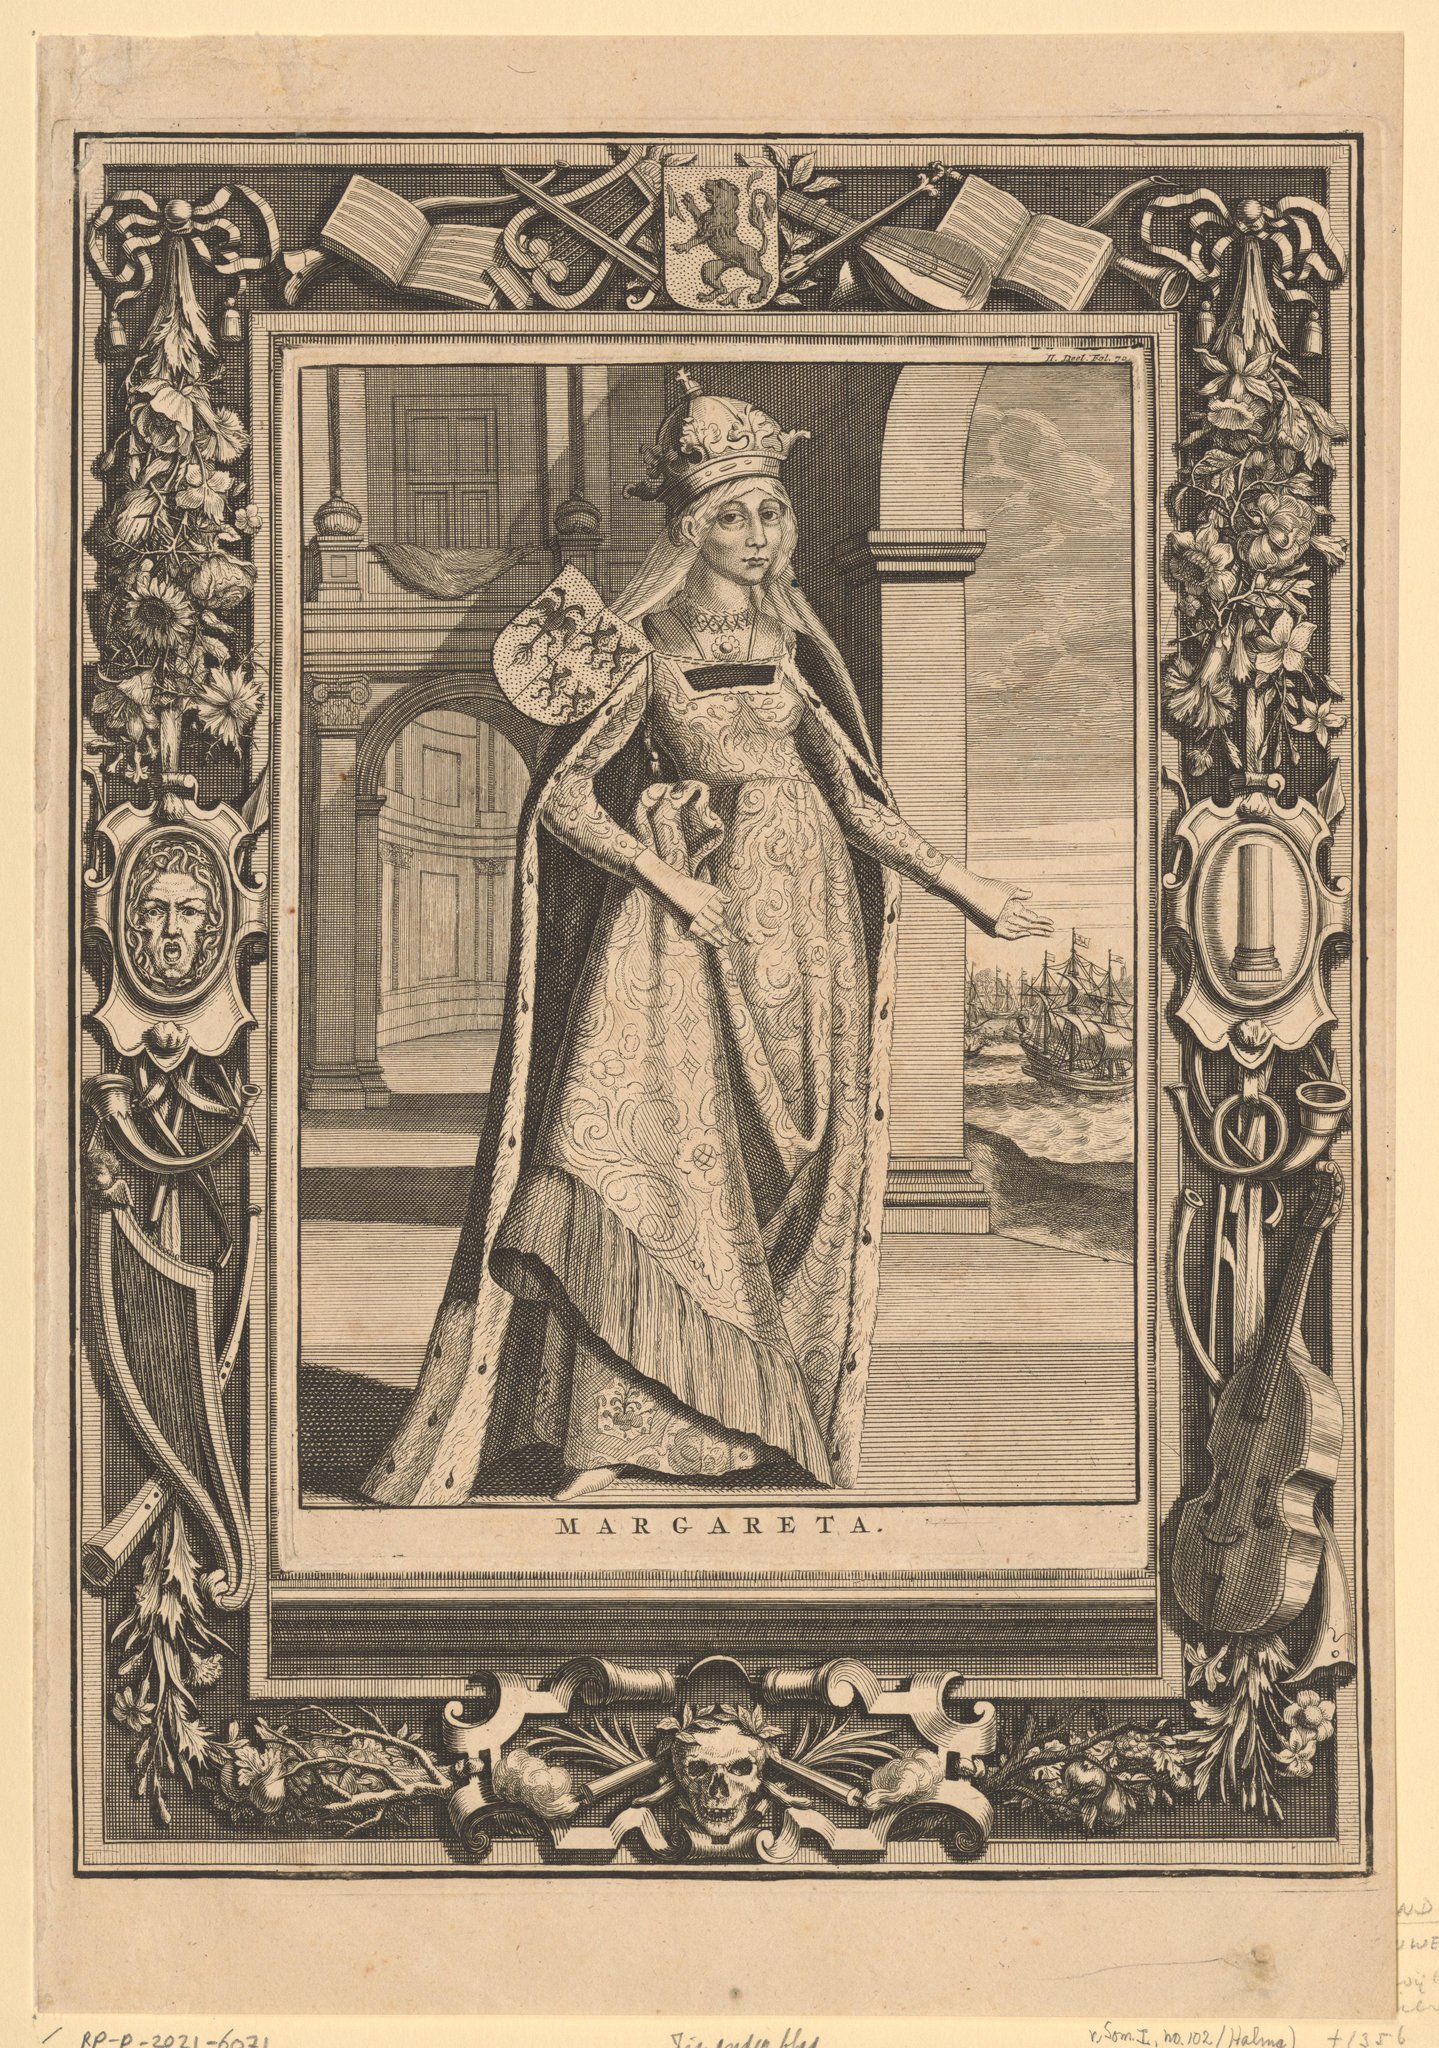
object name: book illustration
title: Portret van Margaretha II van Henegouwen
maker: Anonymous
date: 1725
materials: paper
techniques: etching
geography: northern netherlands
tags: coat of arms (as symbol of the state, etc.), musical instruments; group of musical instruments, sailing-ship, sailing-boat, historical persons - bb - woman, crown (symbol of sovereignty) - bb - female ruler, armorial bearing, heraldry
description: Prent waarschijnlijk uit: Halma, François. Tooneel der Vereenigde Nederlanden, en onderhorige landschappen (...). 2 dln. Leeuwarden: Hendrik Halma, 1725, dl. 2, p. 70. Eerdere staat van prent gebruikt in: Stoke, Melis. Hollandse jaar-boeken of rijm-kronijk van Melis Stoke. Behelsende de geschiedenissen des lands (...). Leiden: Johannes du Vivié en Isaak Severinus, 1699. Derde staat zonder paginanummering gebruikt in 'Korte leevensschets (...)', 1744.